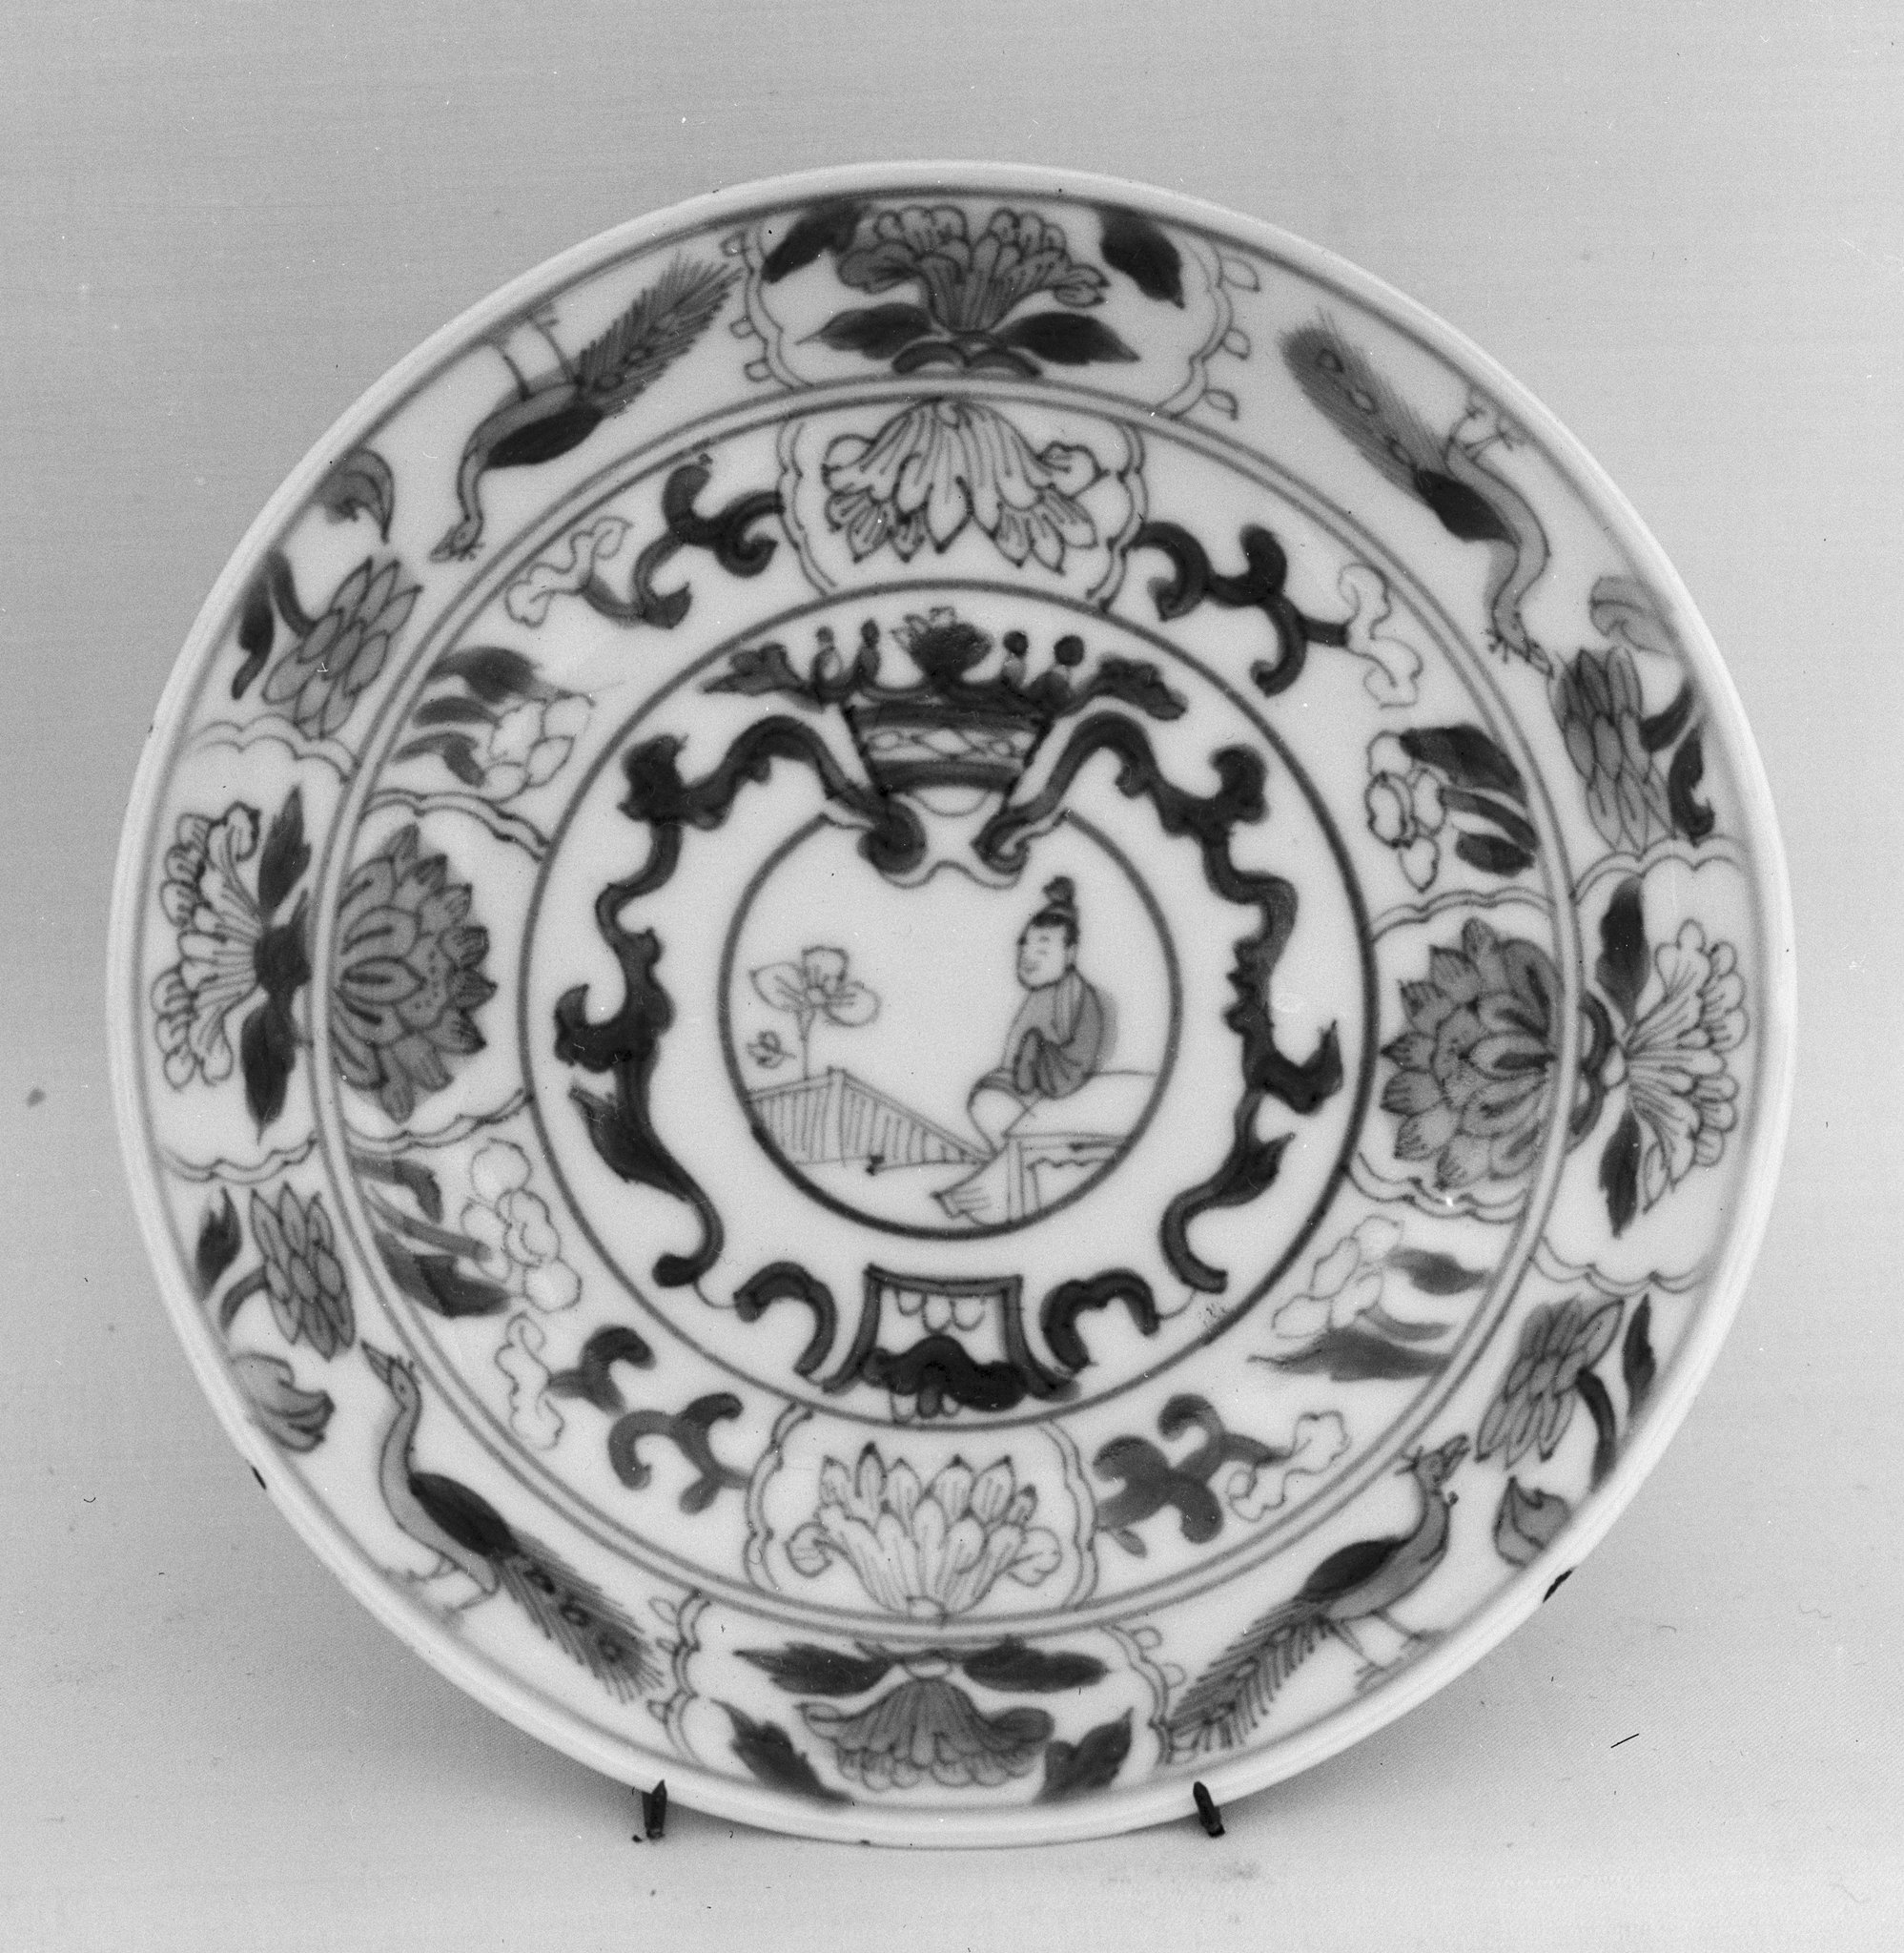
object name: saucer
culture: chinese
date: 1644-1911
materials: porcelain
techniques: painting, underglaze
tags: peacocks